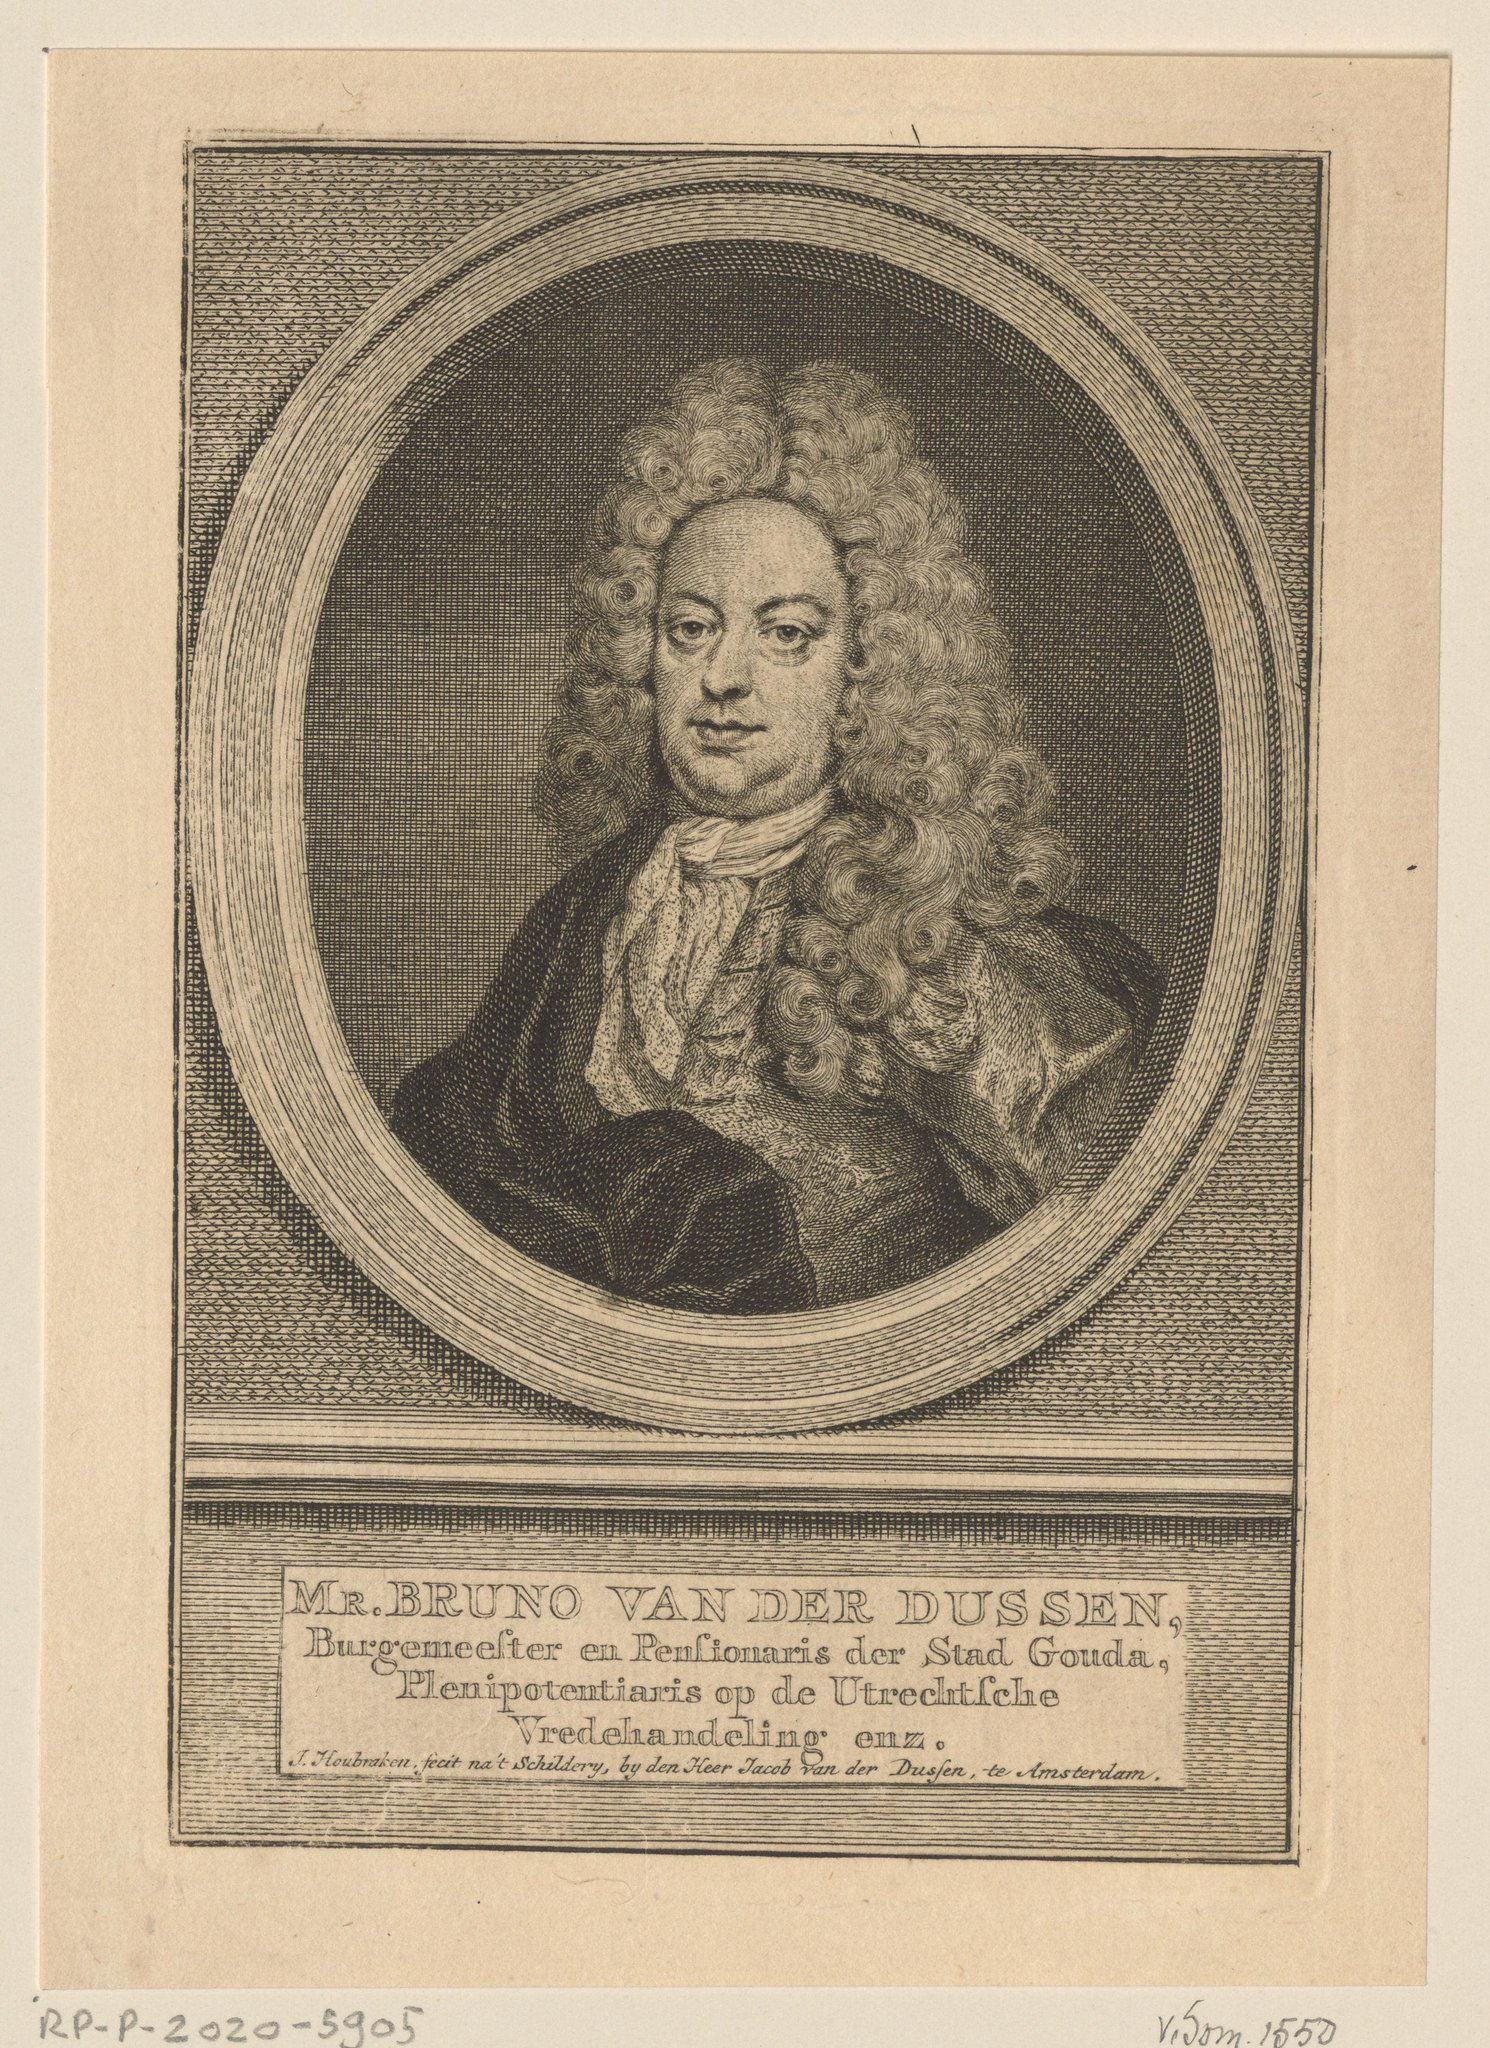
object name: print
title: Portret van Bruno van der Dussen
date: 1720-1780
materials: paper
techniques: engraving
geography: amsterdam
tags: mayor, bruno van der dussen, historical persons